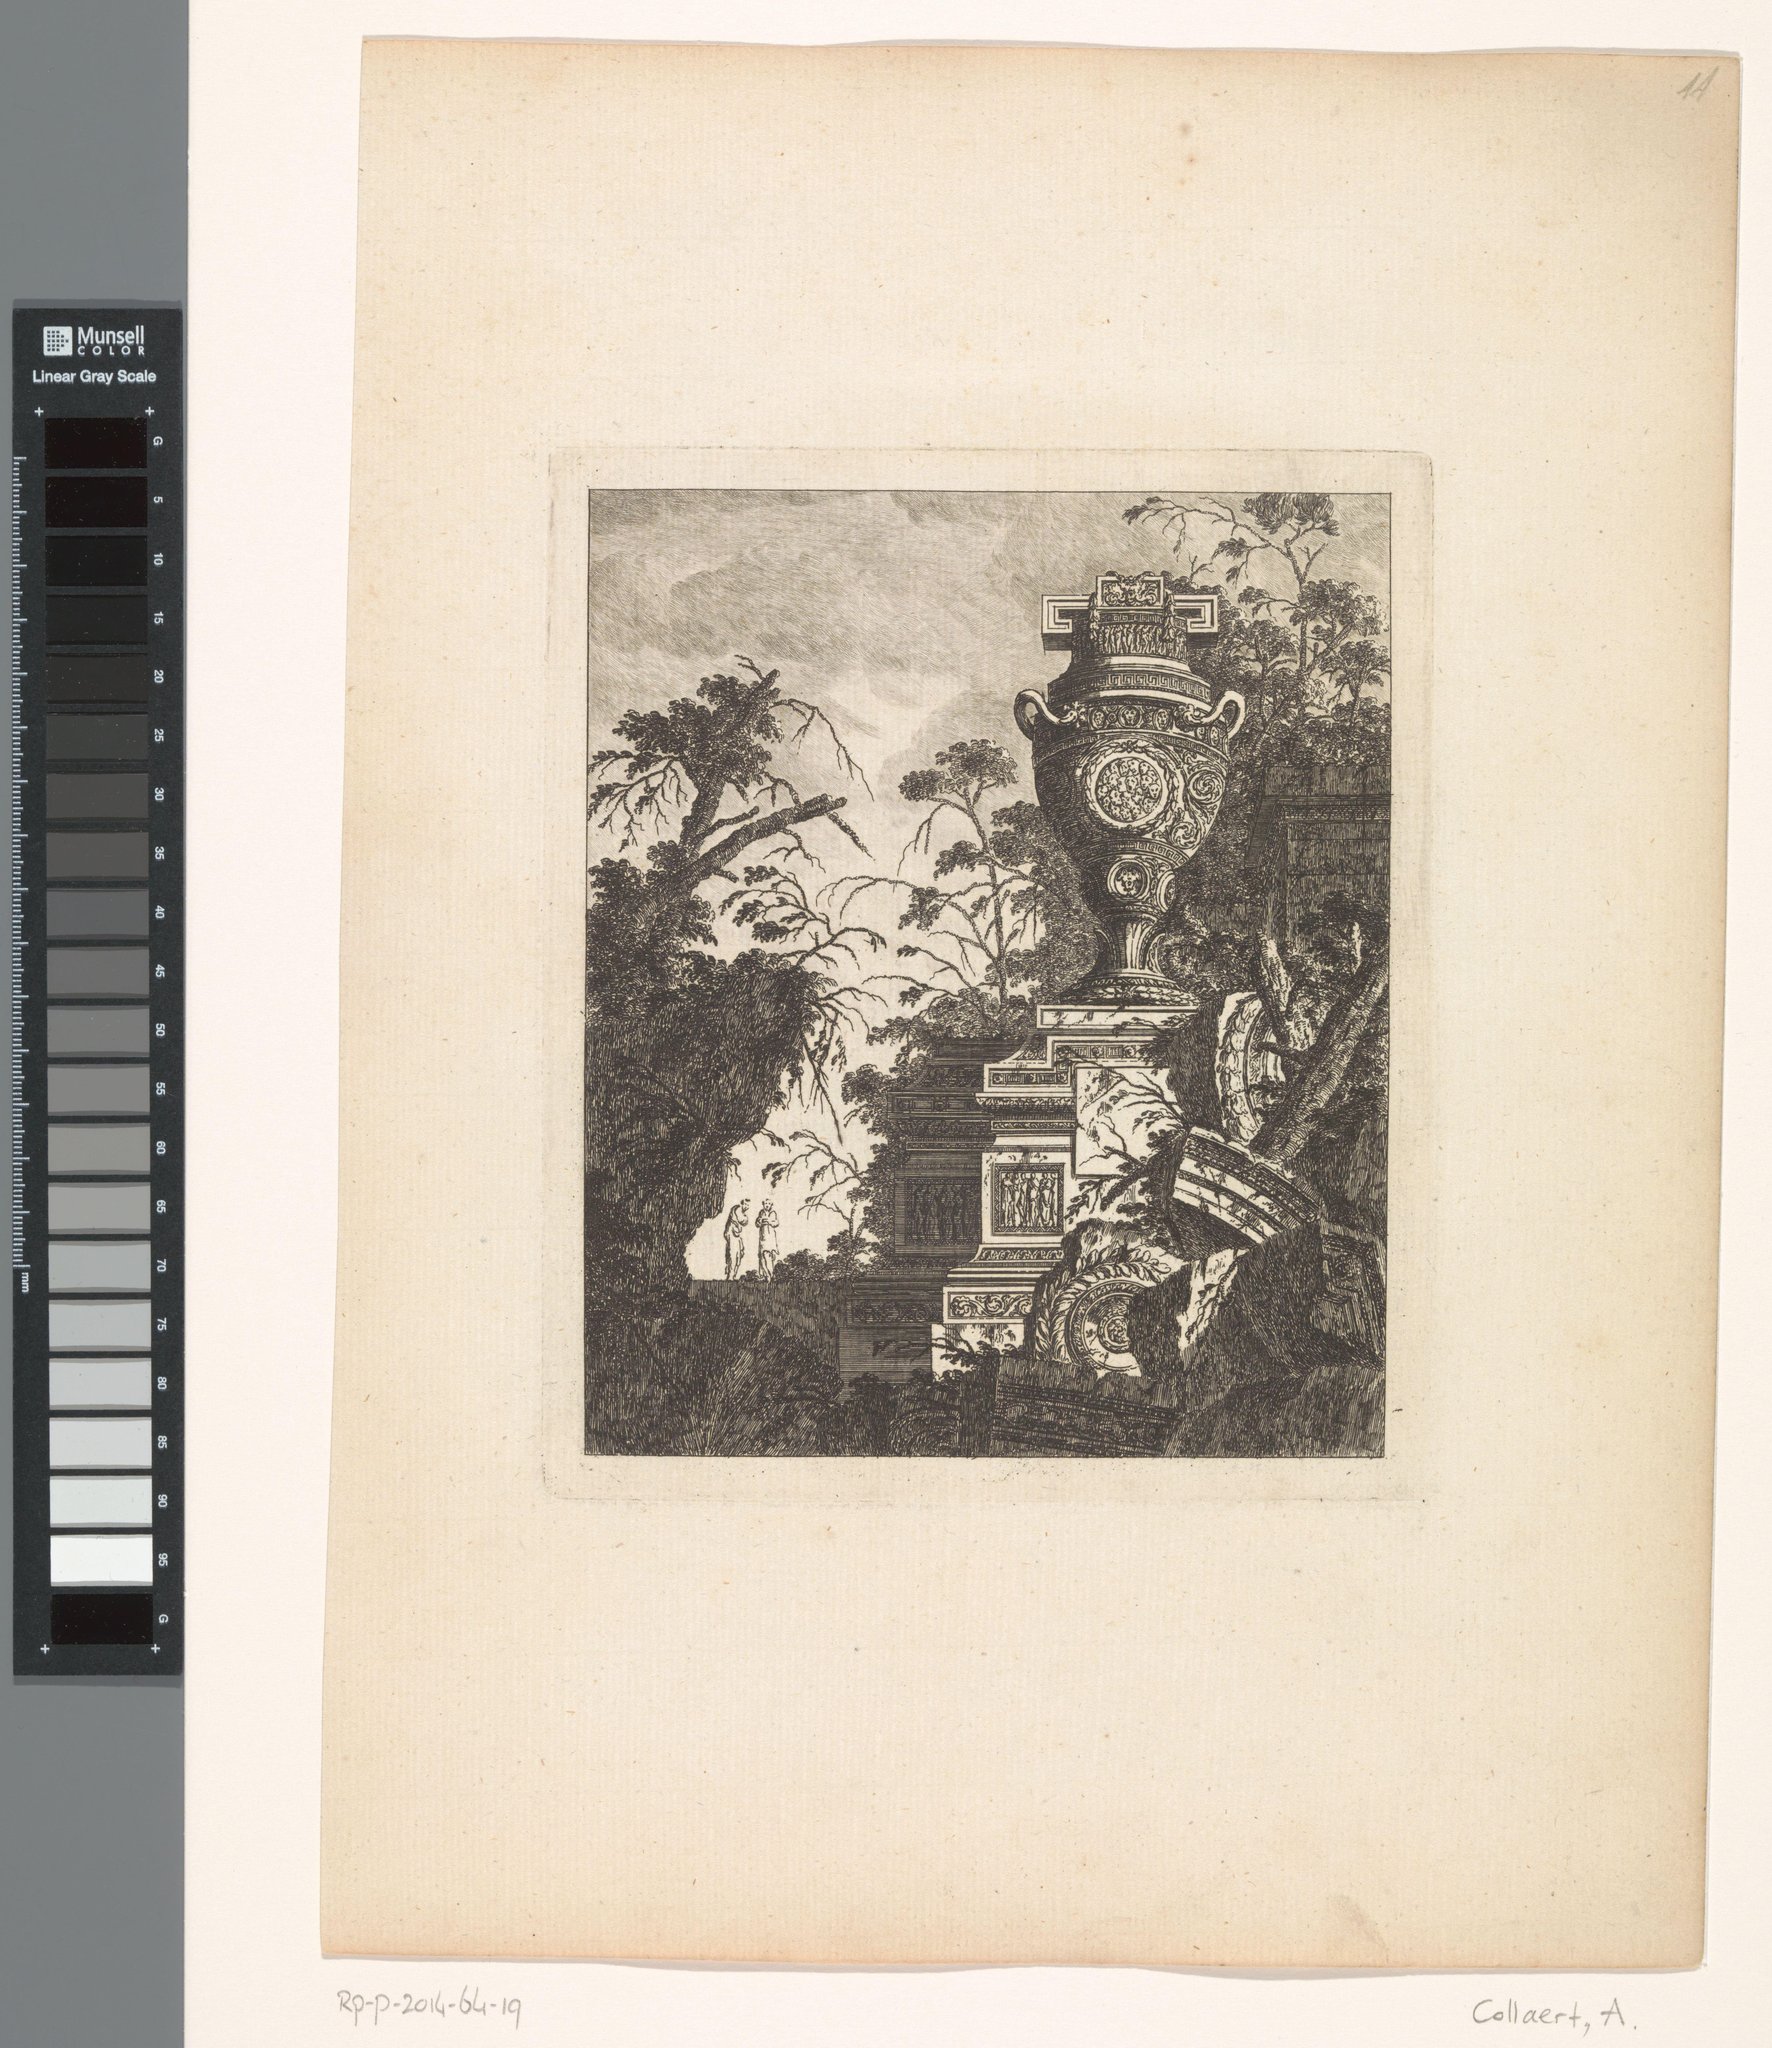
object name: print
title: Landschap met ruïnes en groteske vaas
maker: jean laurent legeay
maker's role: print maker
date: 1767-1770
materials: paper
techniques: etching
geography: france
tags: vase ~ ornament, landscape with ruins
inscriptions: collector's mark: Lugt 2760, collector's mark: Lugt 2228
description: Landschap met ruïnes en groteske vaas, links twee staande figuren. In een latere staat genummerd: 22. Onderdeel van groep prenten afkomstig uit één van de vier series van vazen, ruïnes, tombes en fonteinen met in totaal ca. 25 bladen.